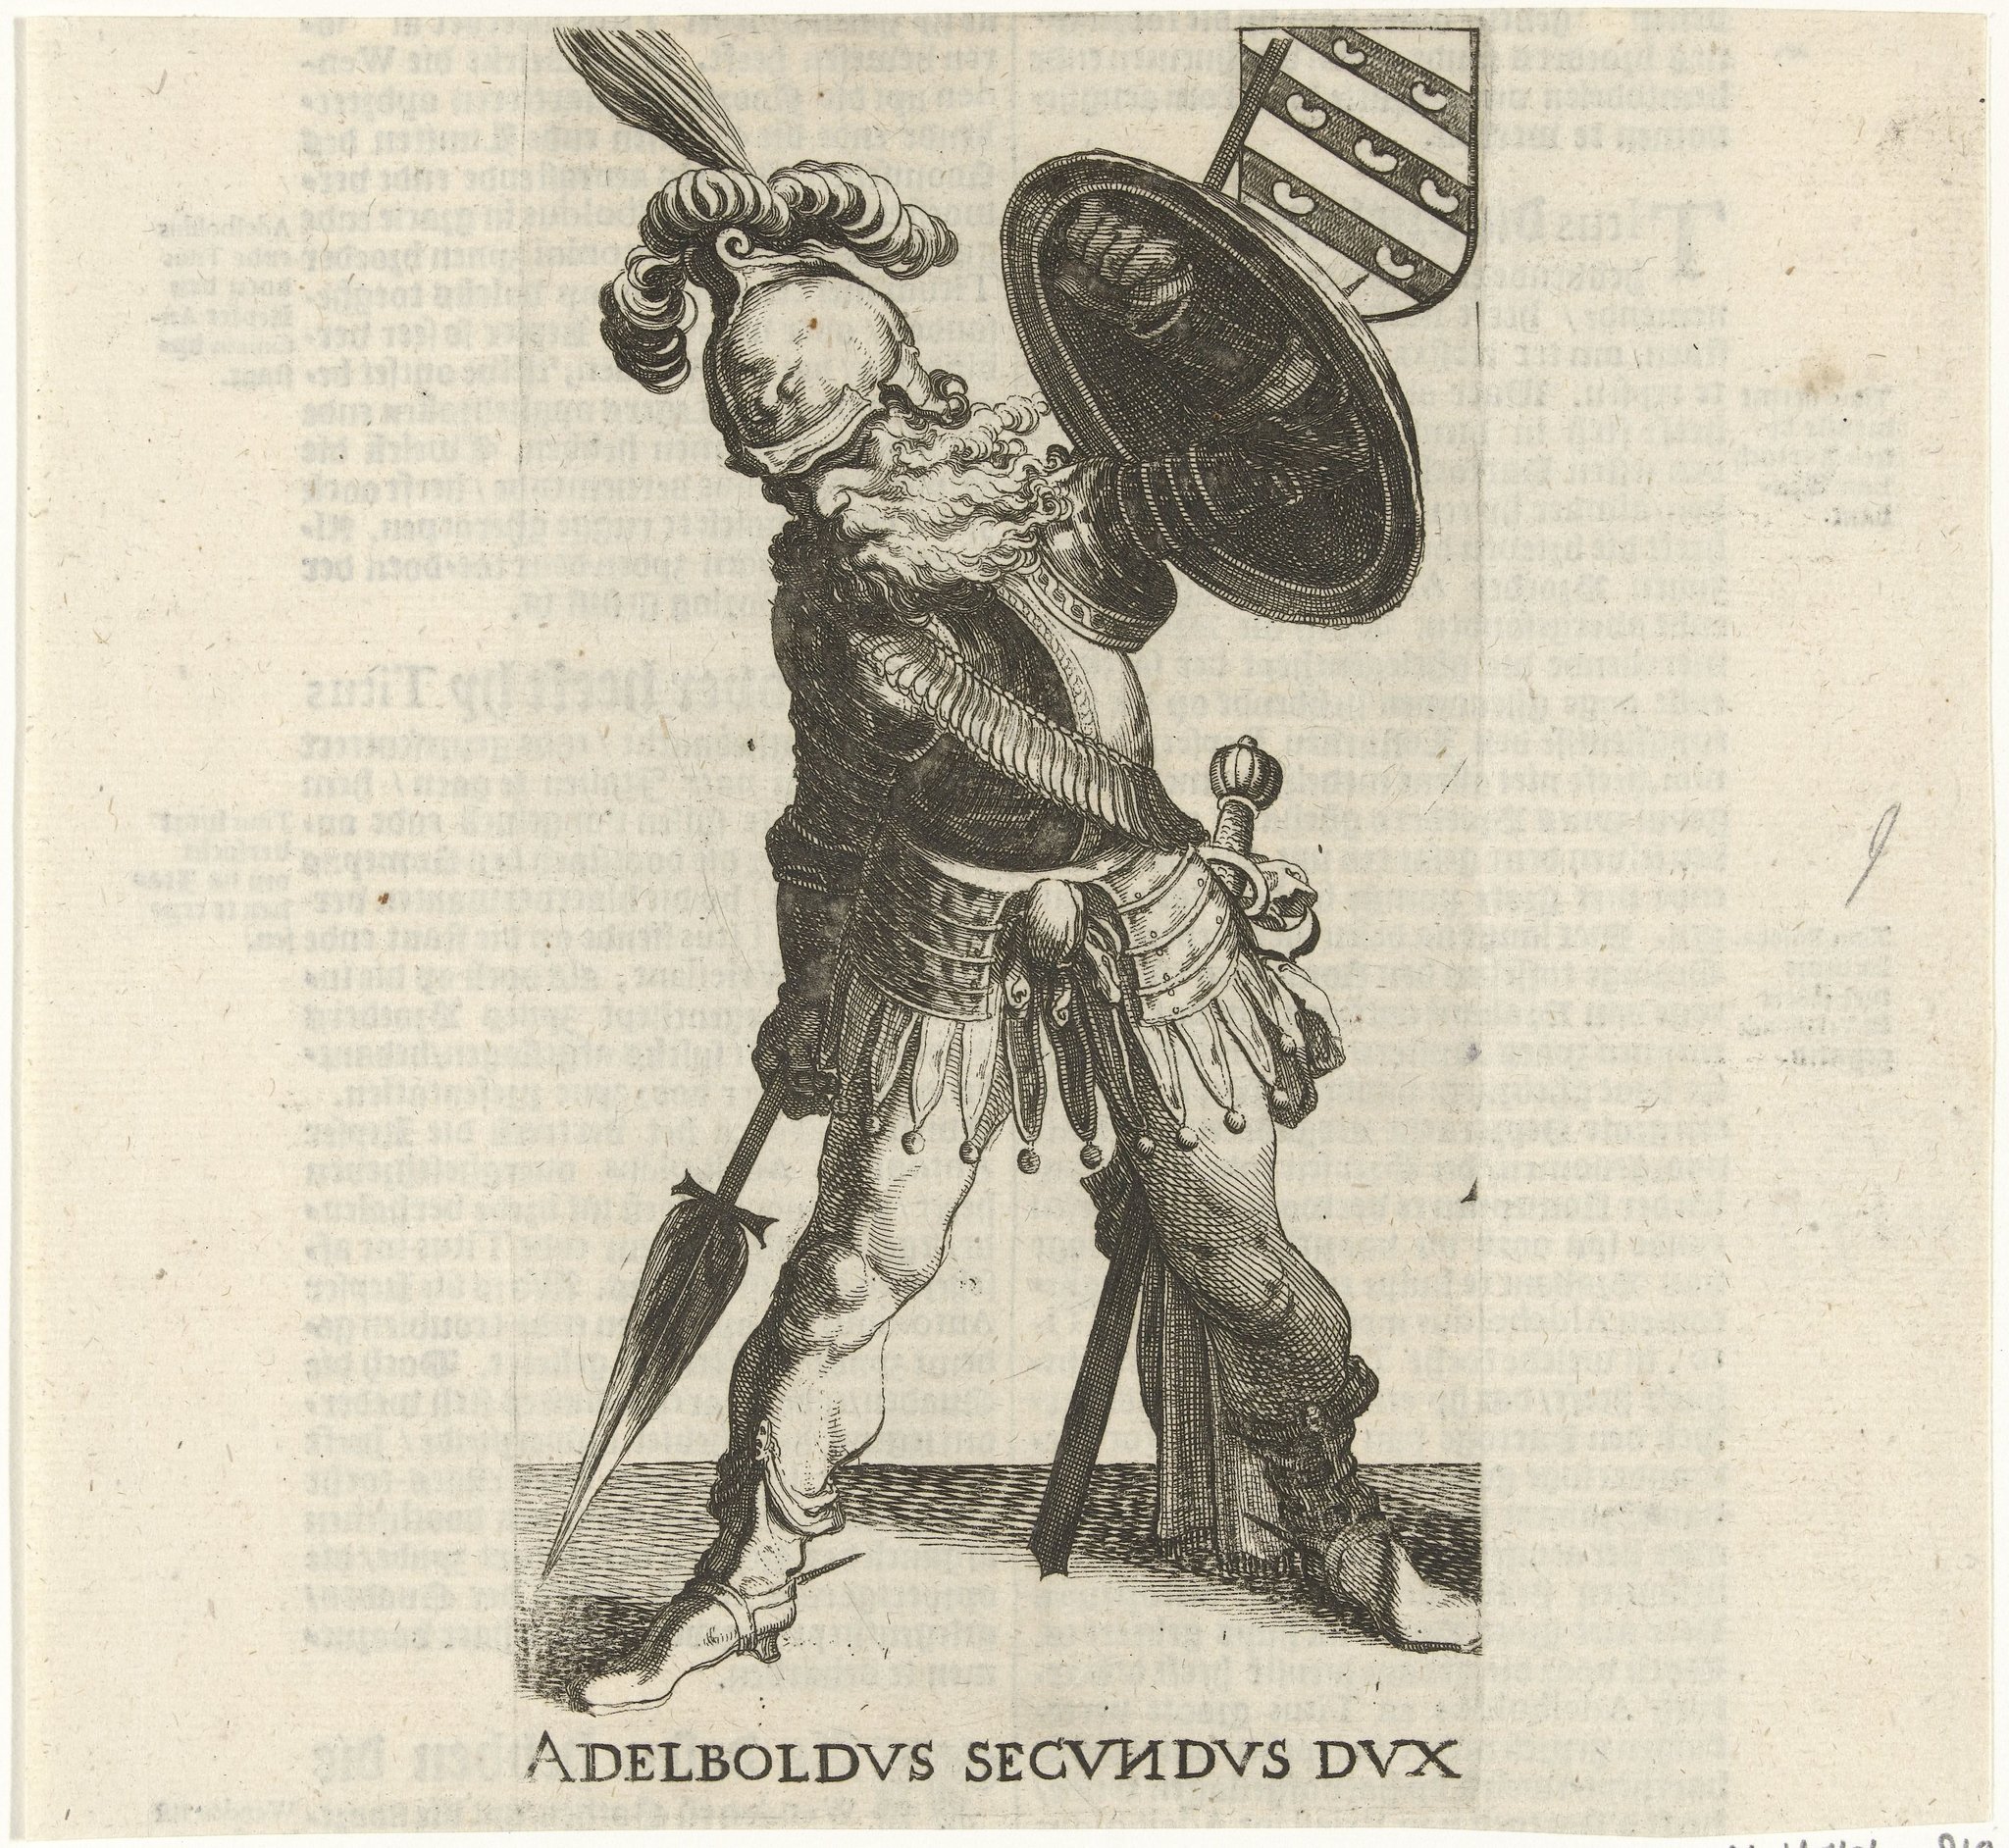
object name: print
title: Friese heersers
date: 1622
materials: paper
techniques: etching, letterpress printing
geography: northern netherlands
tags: hertog, adelbold (hertog der friezen)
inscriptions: collector's mark: Lugt 2228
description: De prent is ook als boekillustratie gebruikt in: Winsemius, P.W. Chronique ofte Historische geschiedenisse van Vrieslant (...). Franeker: Joannes Lamrinck, 1622.